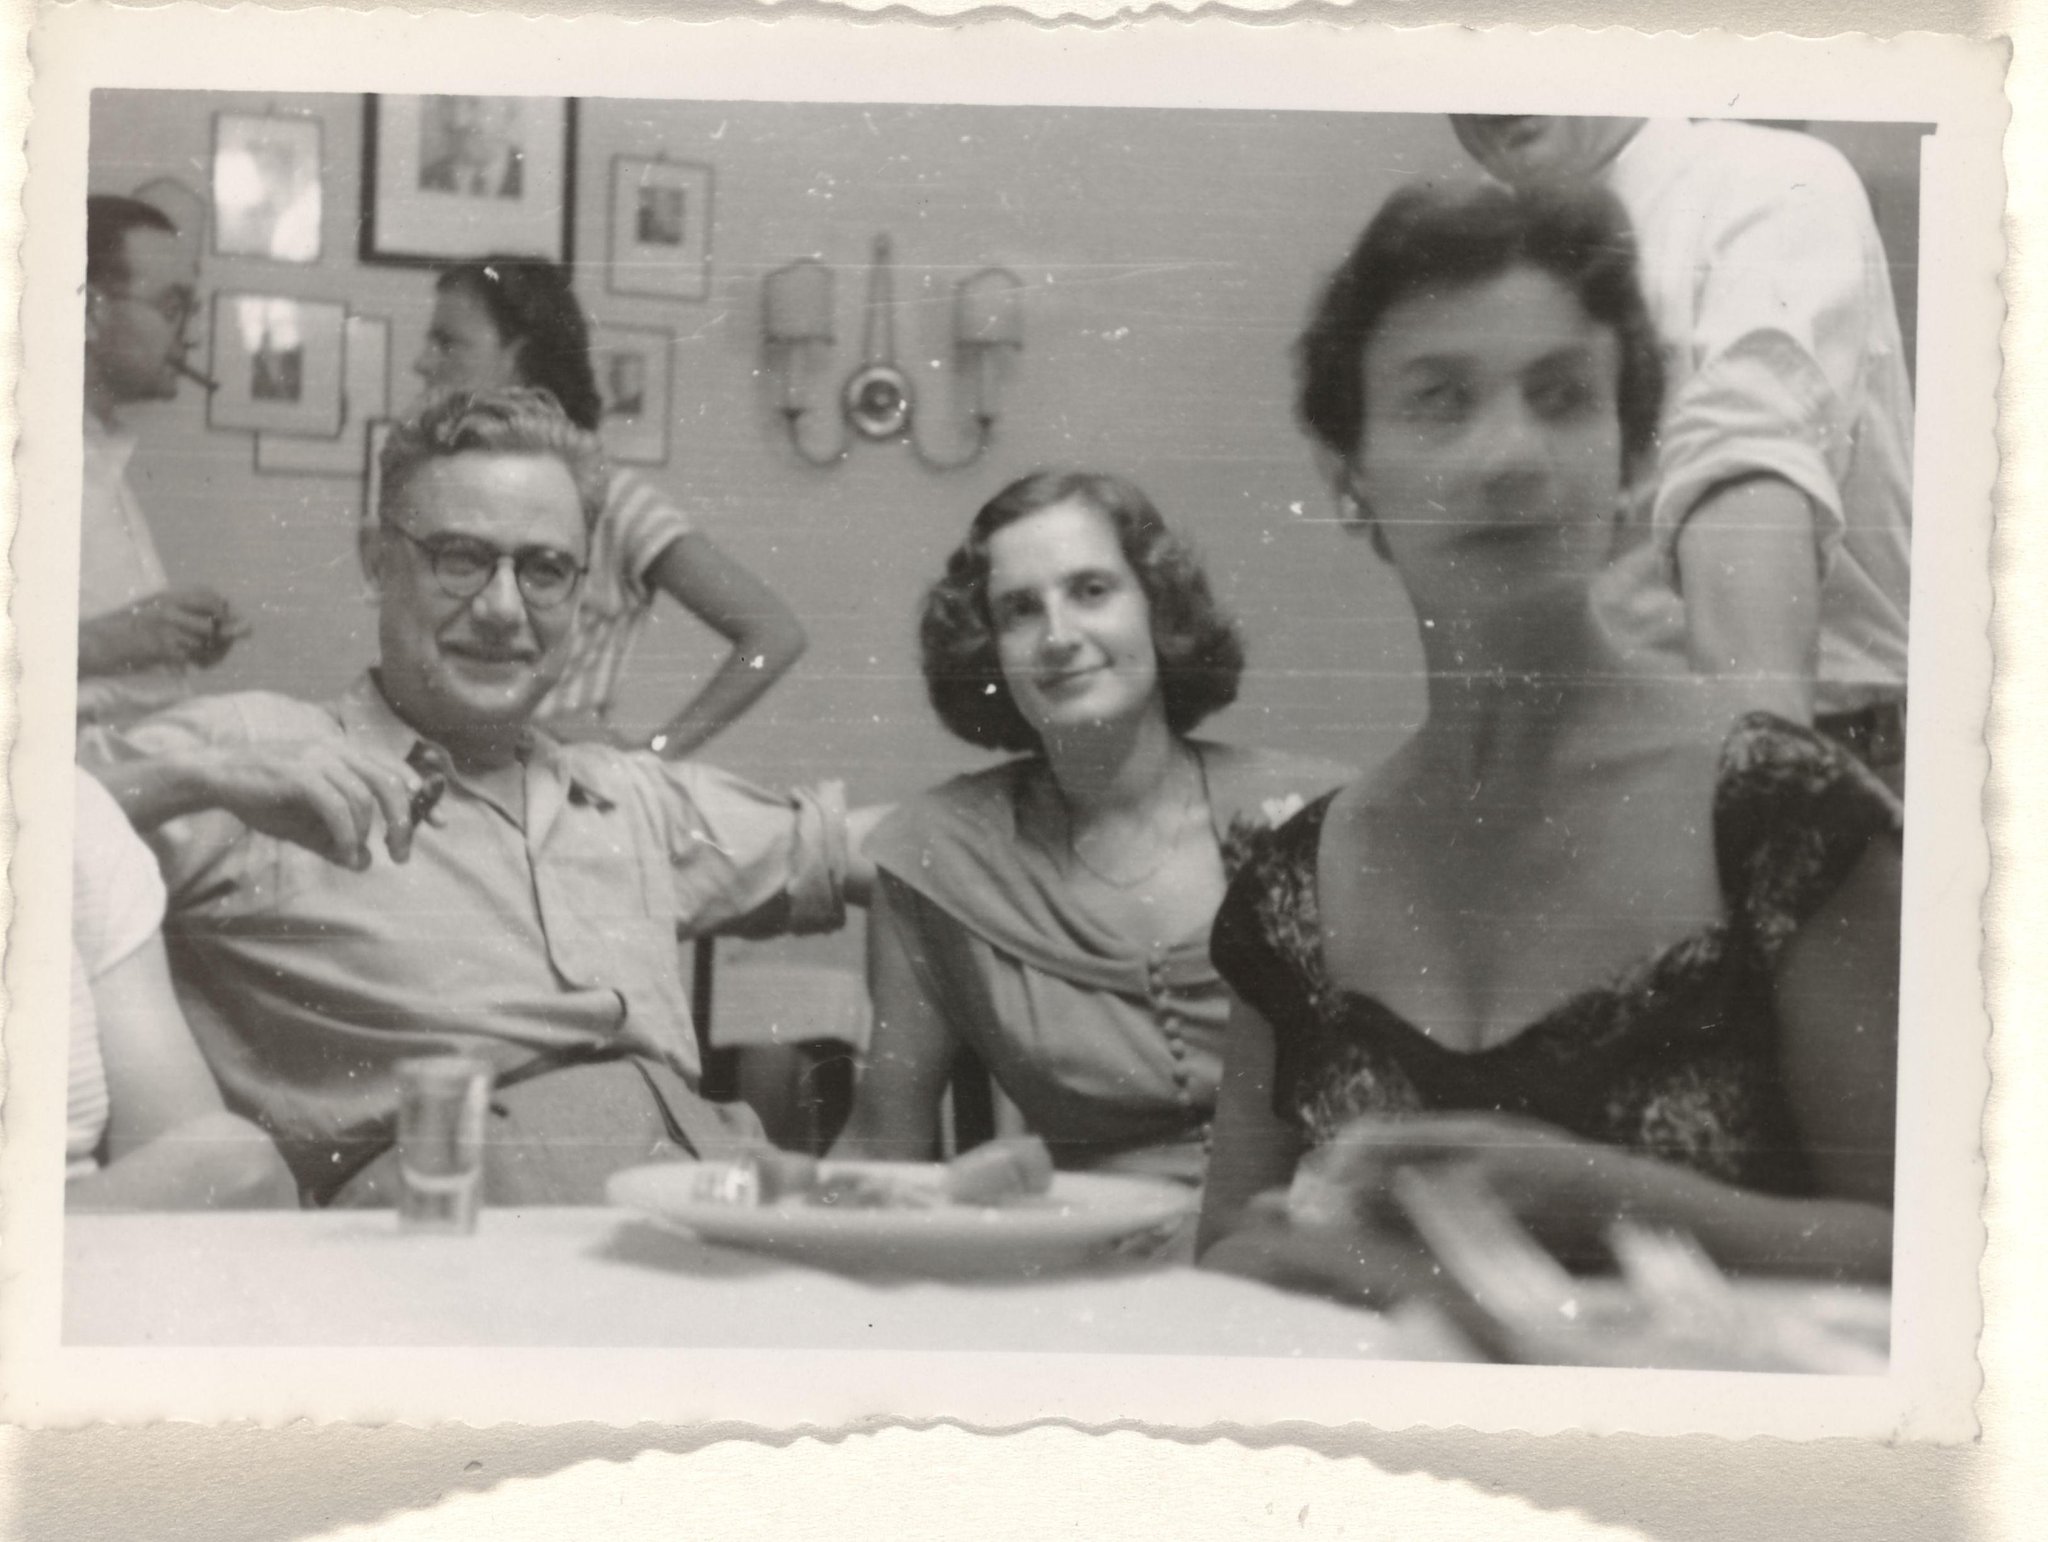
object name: photograph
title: Isabel Wachenheimer met een onbekende man en een onbekende vrouw tijdens een banket voor de armen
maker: Anonymous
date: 1946-1963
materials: photographic support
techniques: gelatin silver print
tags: leiden, isabel wachenheimer-elon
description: Isabel Wachenheimer (midden) met een onbekende man en een onbekende vrouw tijdens een banket.